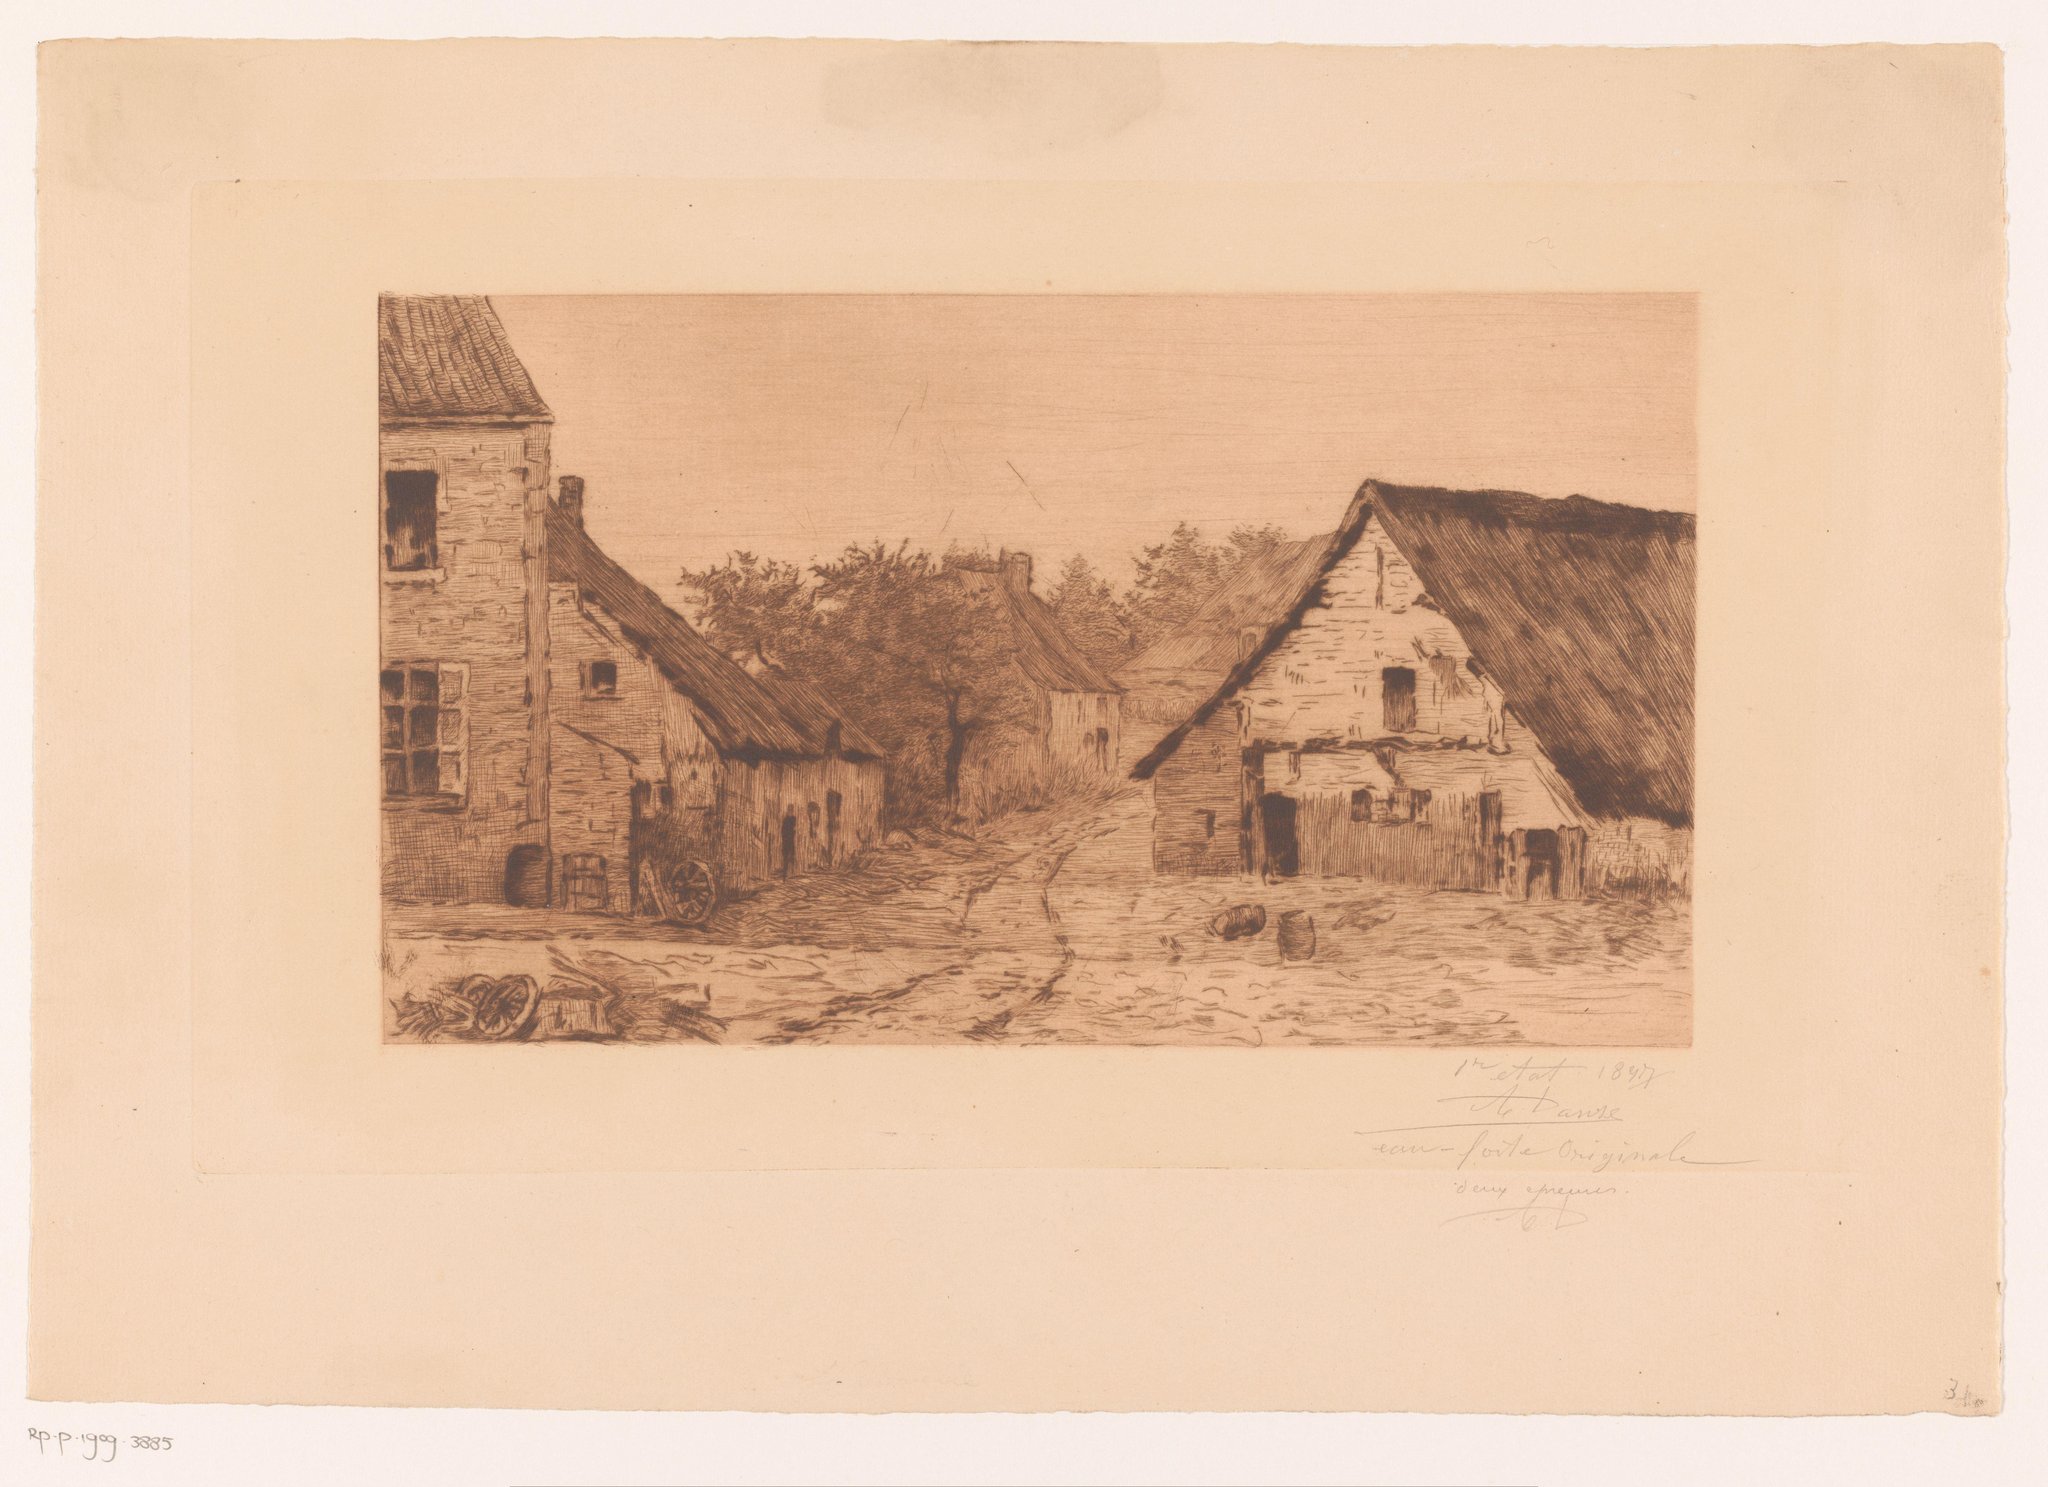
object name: print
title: Dorpsgezicht met rietgedekte gebouwen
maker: auguste danse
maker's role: print maker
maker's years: 1829-1929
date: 1897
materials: paper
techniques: drypoint, etching, intaglio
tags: village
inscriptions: annotation: ‘1er etat; eau-forte originale; deux epreuves’, collector's mark: Lugt 2228